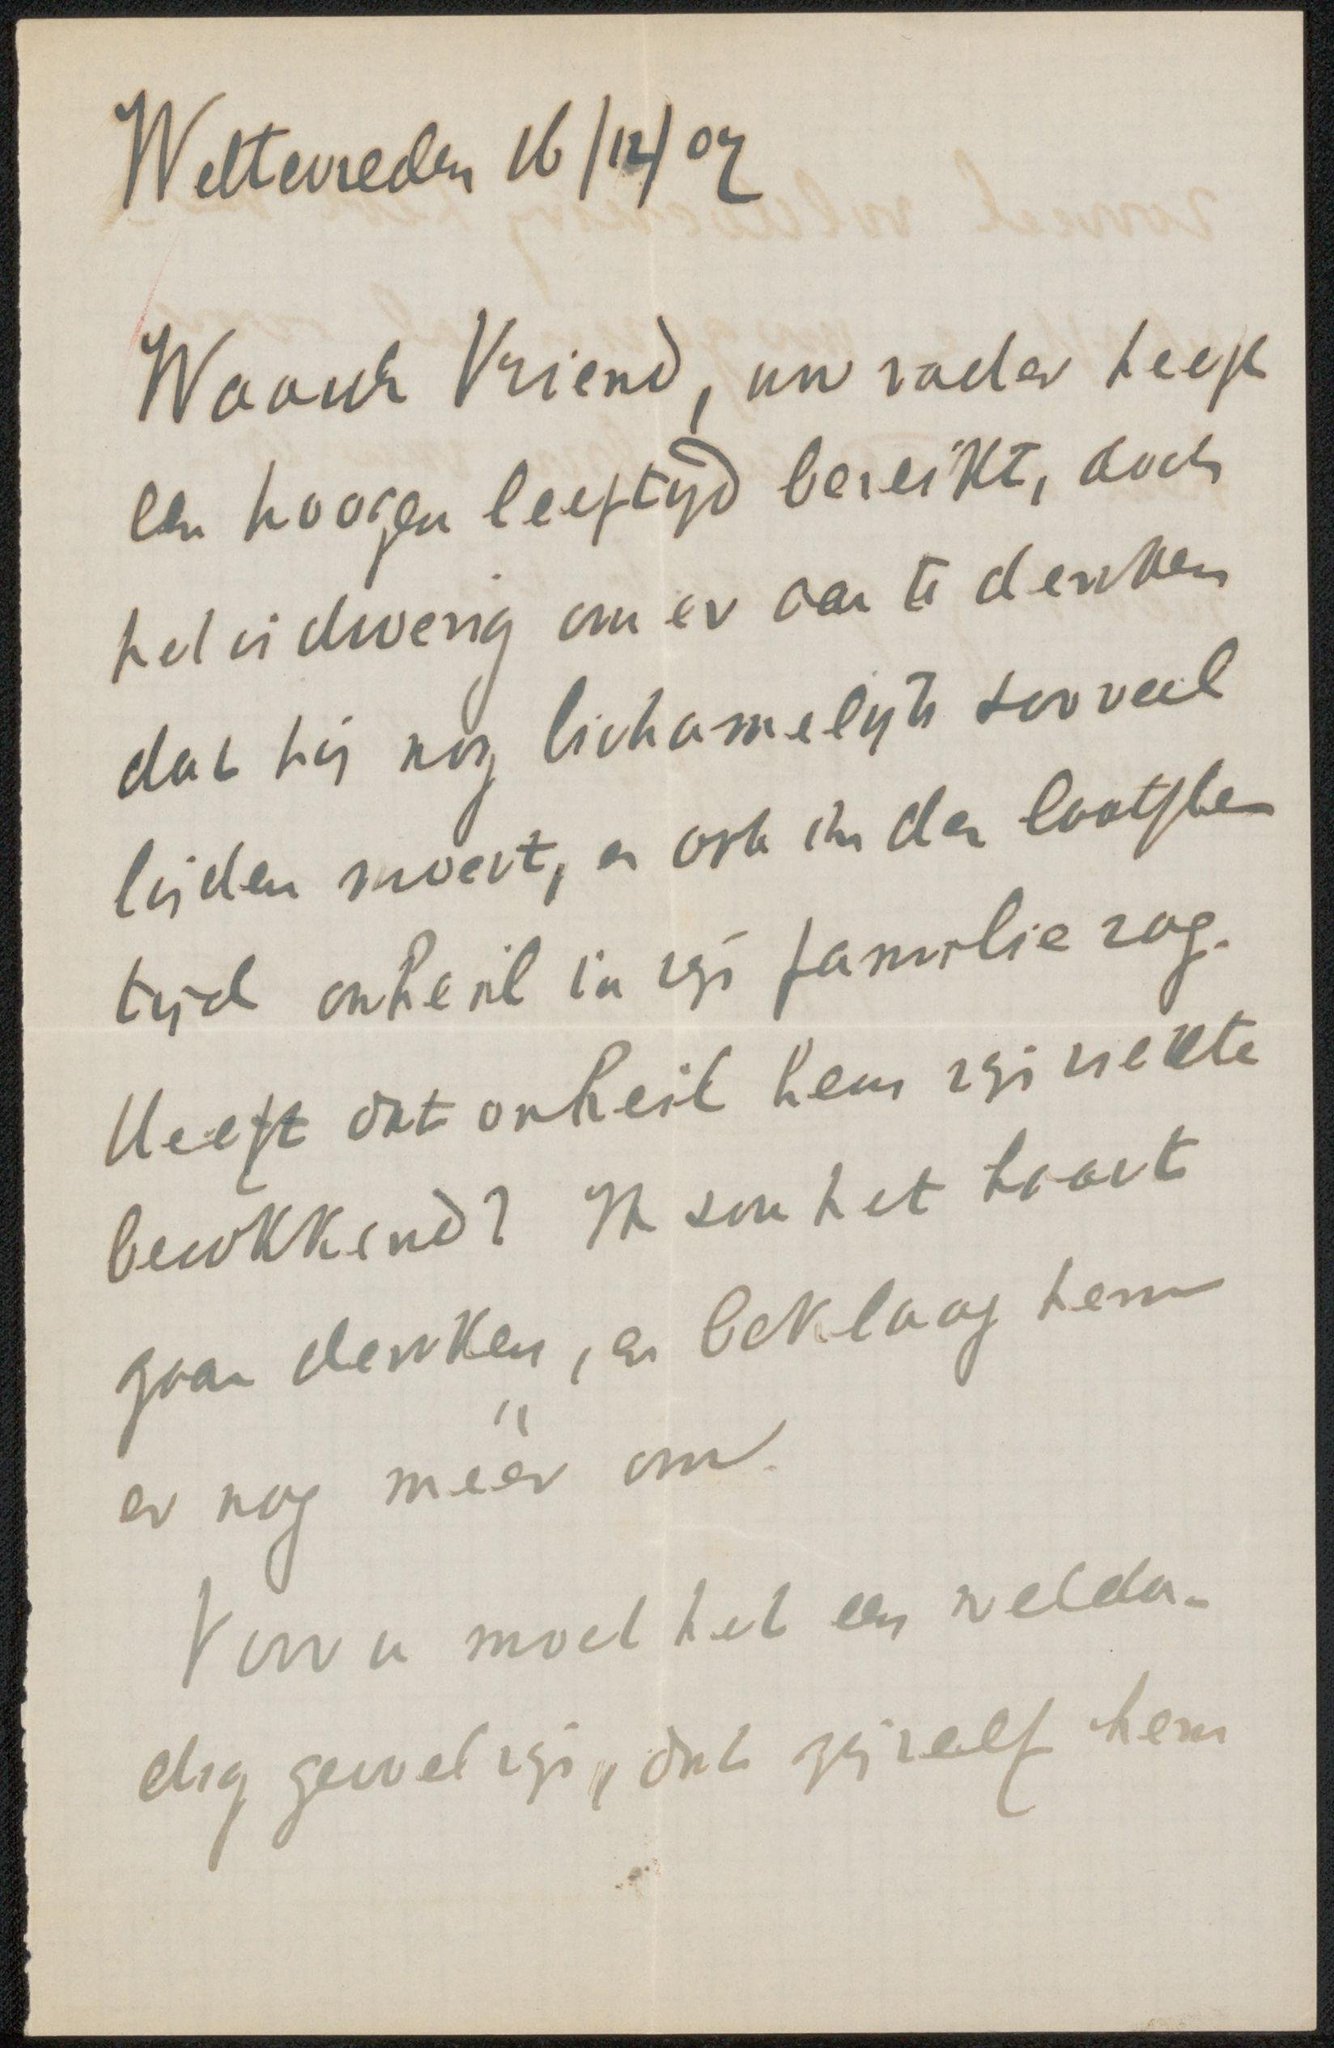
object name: letter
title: Brief aan Jan Veth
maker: chap van deventer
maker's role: kunstcriticus, scheikundige, schrijver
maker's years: 1860-1931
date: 1907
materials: ink, paper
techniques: pen, writing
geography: weltevreden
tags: dordrecht, amsterdam, painter, print maker, draughtsman, designer, jan veth, family life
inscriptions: collector's mark: ‘RPK’